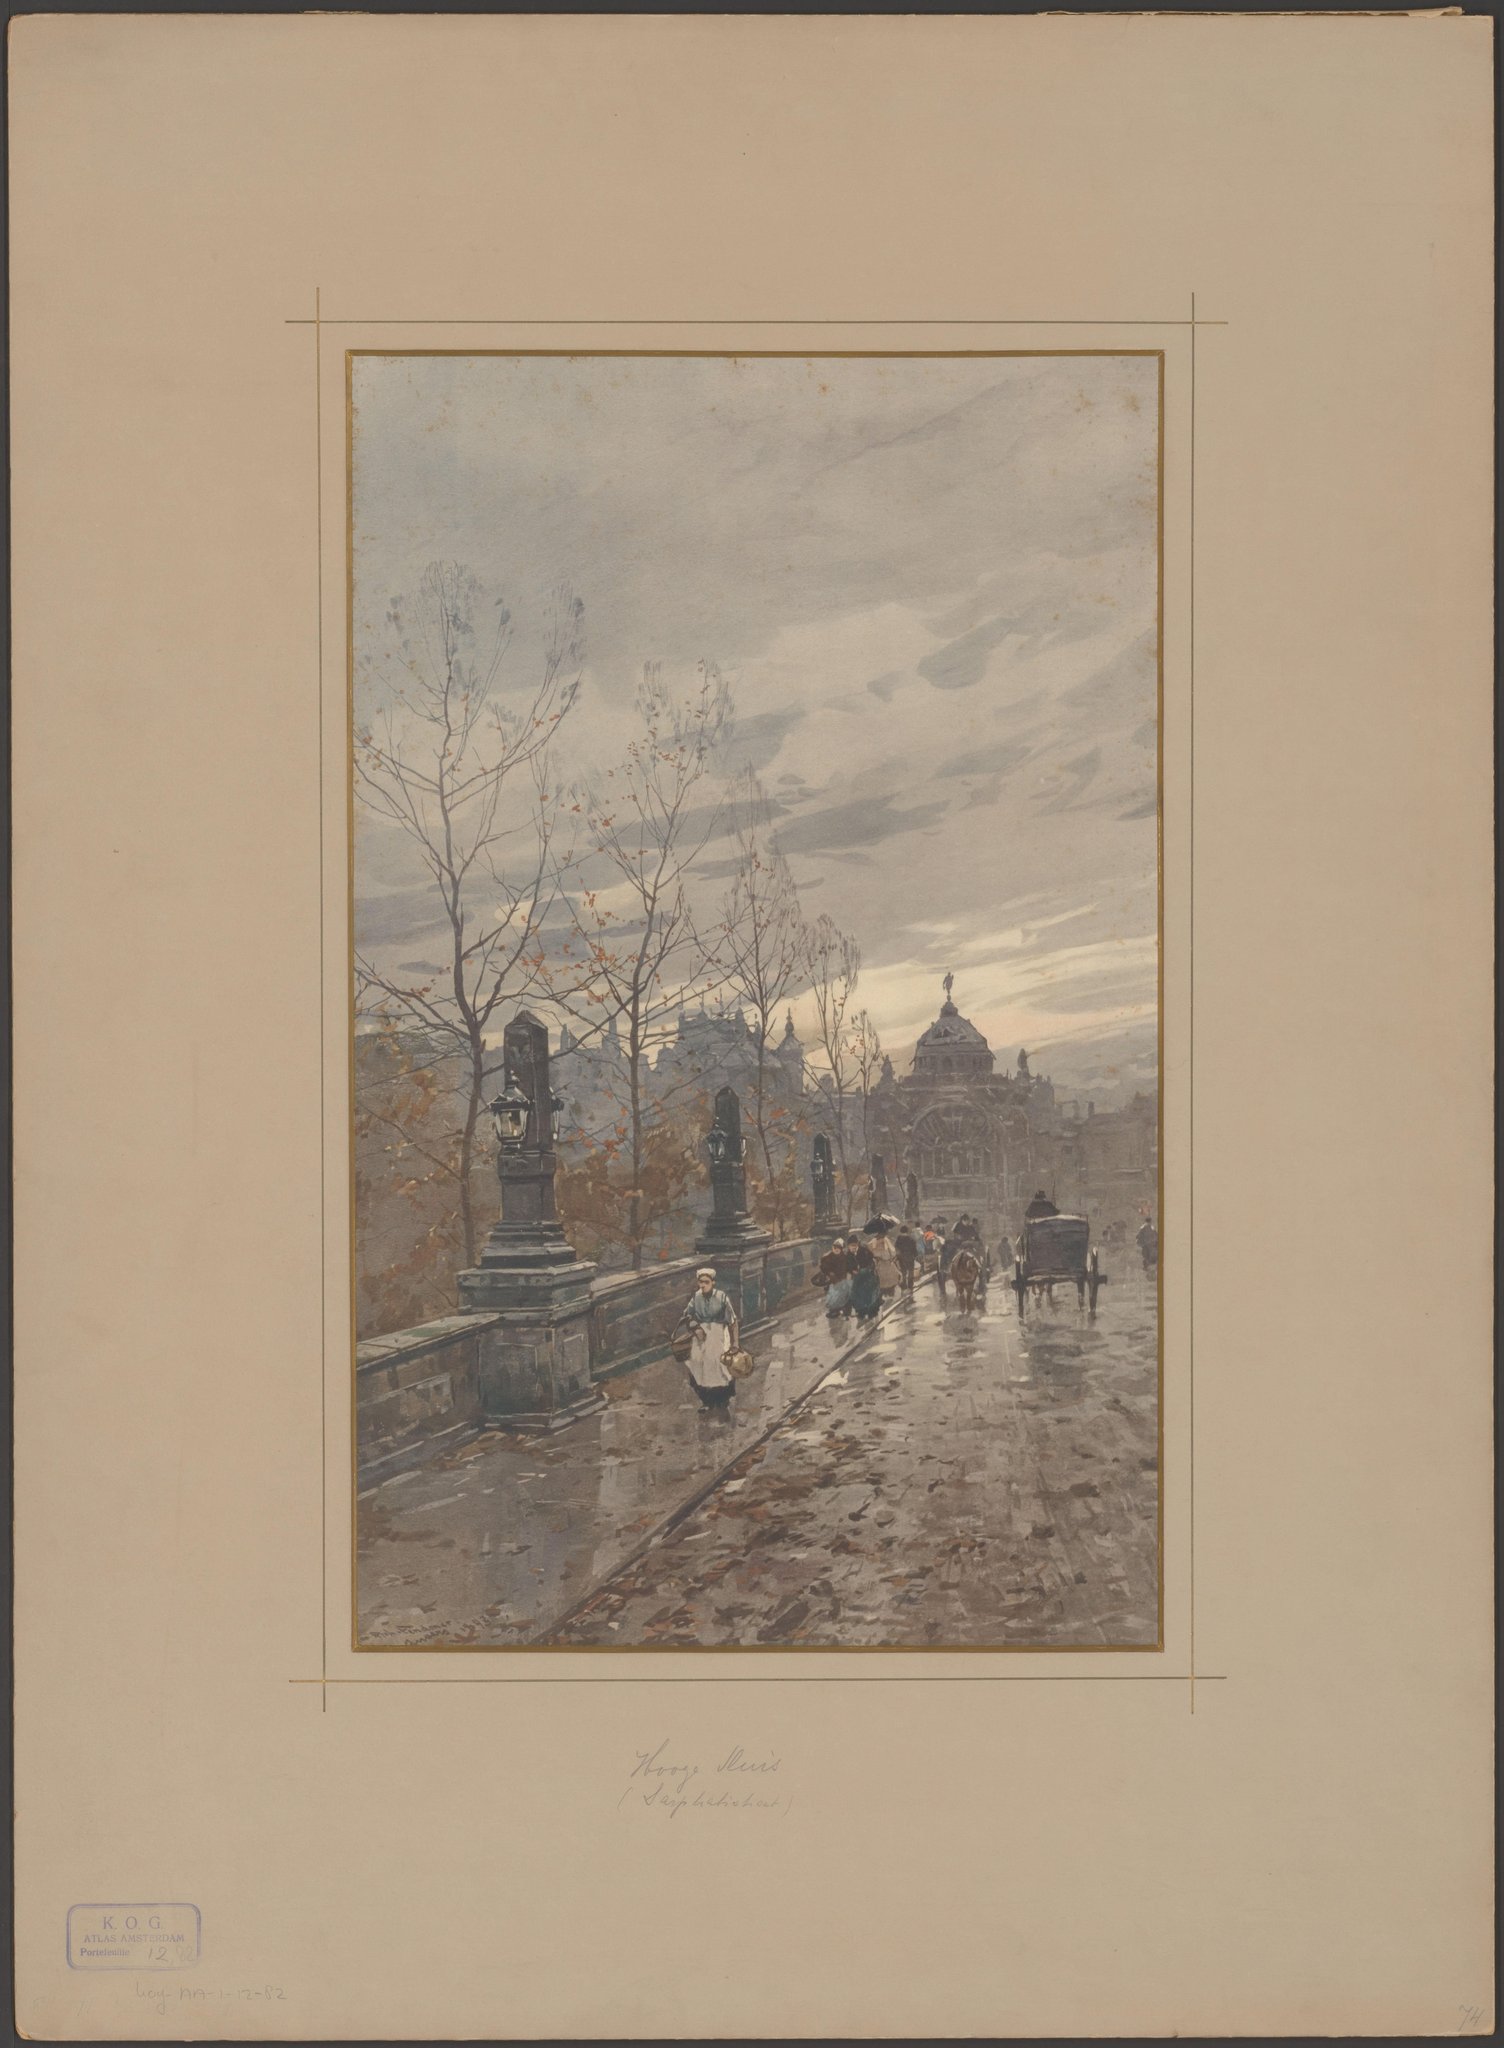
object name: photomechanical print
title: Gezicht op het Paleis voor Volksvlijt vanaf de Sarphatistraat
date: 1893-1930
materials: cardboard, paint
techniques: photograph, hand coloring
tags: city-view in general; 'veduta', permanent exhibition, museum, street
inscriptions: inscription: ‘Hooge Sluis / (Sarphatistraat)’, collector's mark: ‘12,82’ Lugt 1641b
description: Onderwerpsrubriek binnen de Atlas Amsterdam: Sarphatistraat, Schans.